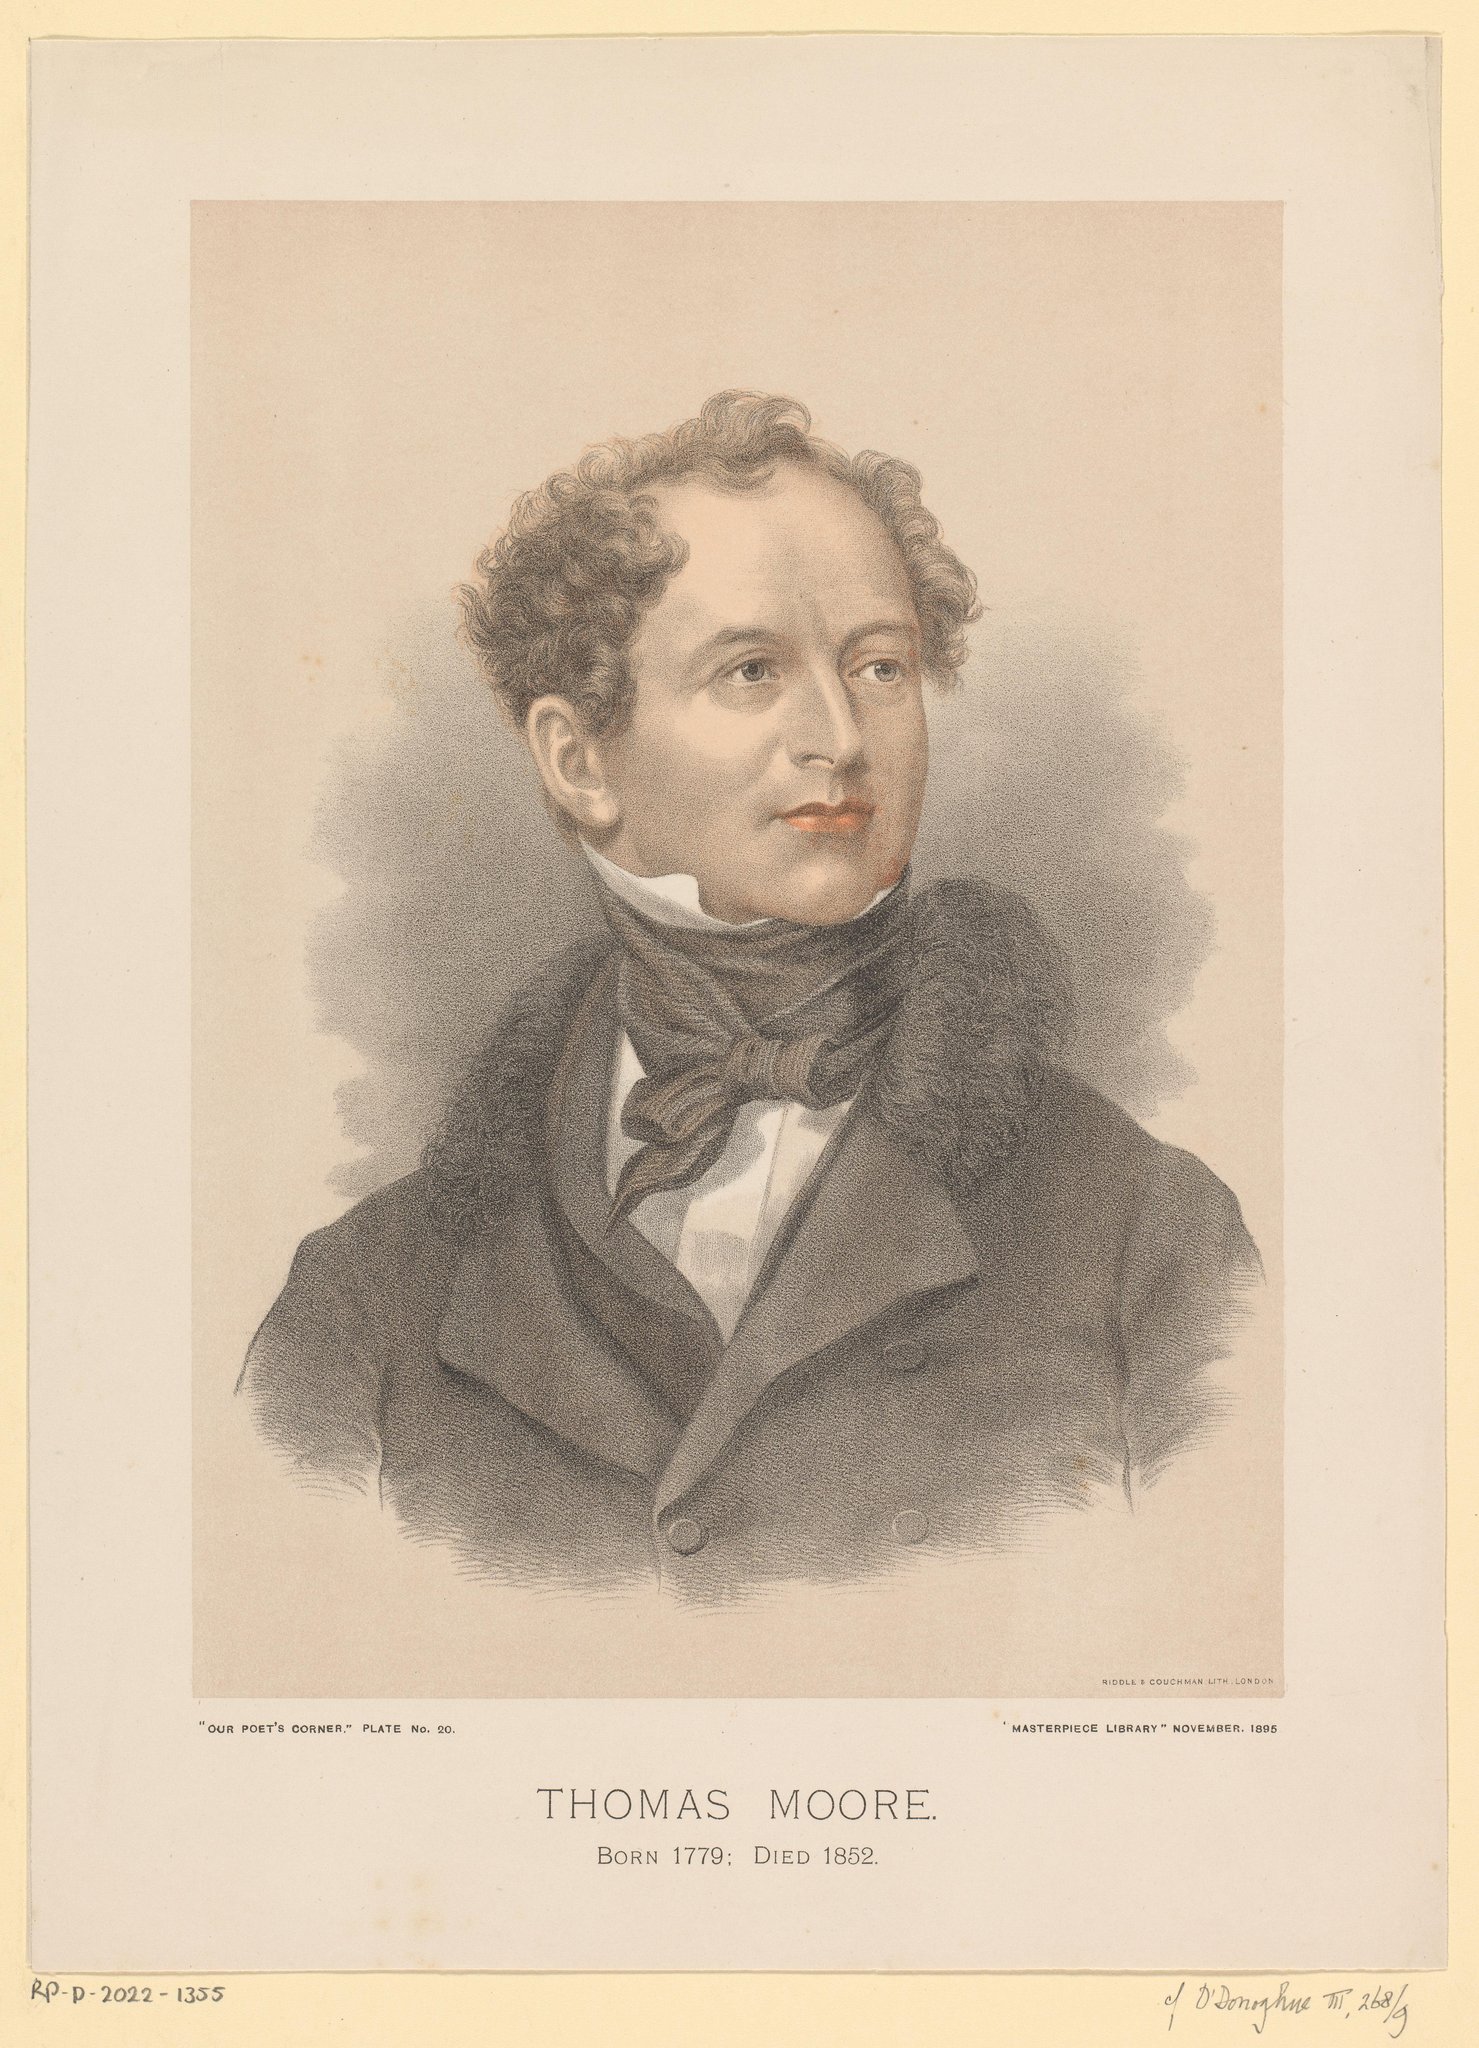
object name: print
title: Our Poets' Corner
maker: Anonymous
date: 1811-1895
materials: paper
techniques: tone lithography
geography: london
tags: thomas moore, historical persons, writer, poet, author